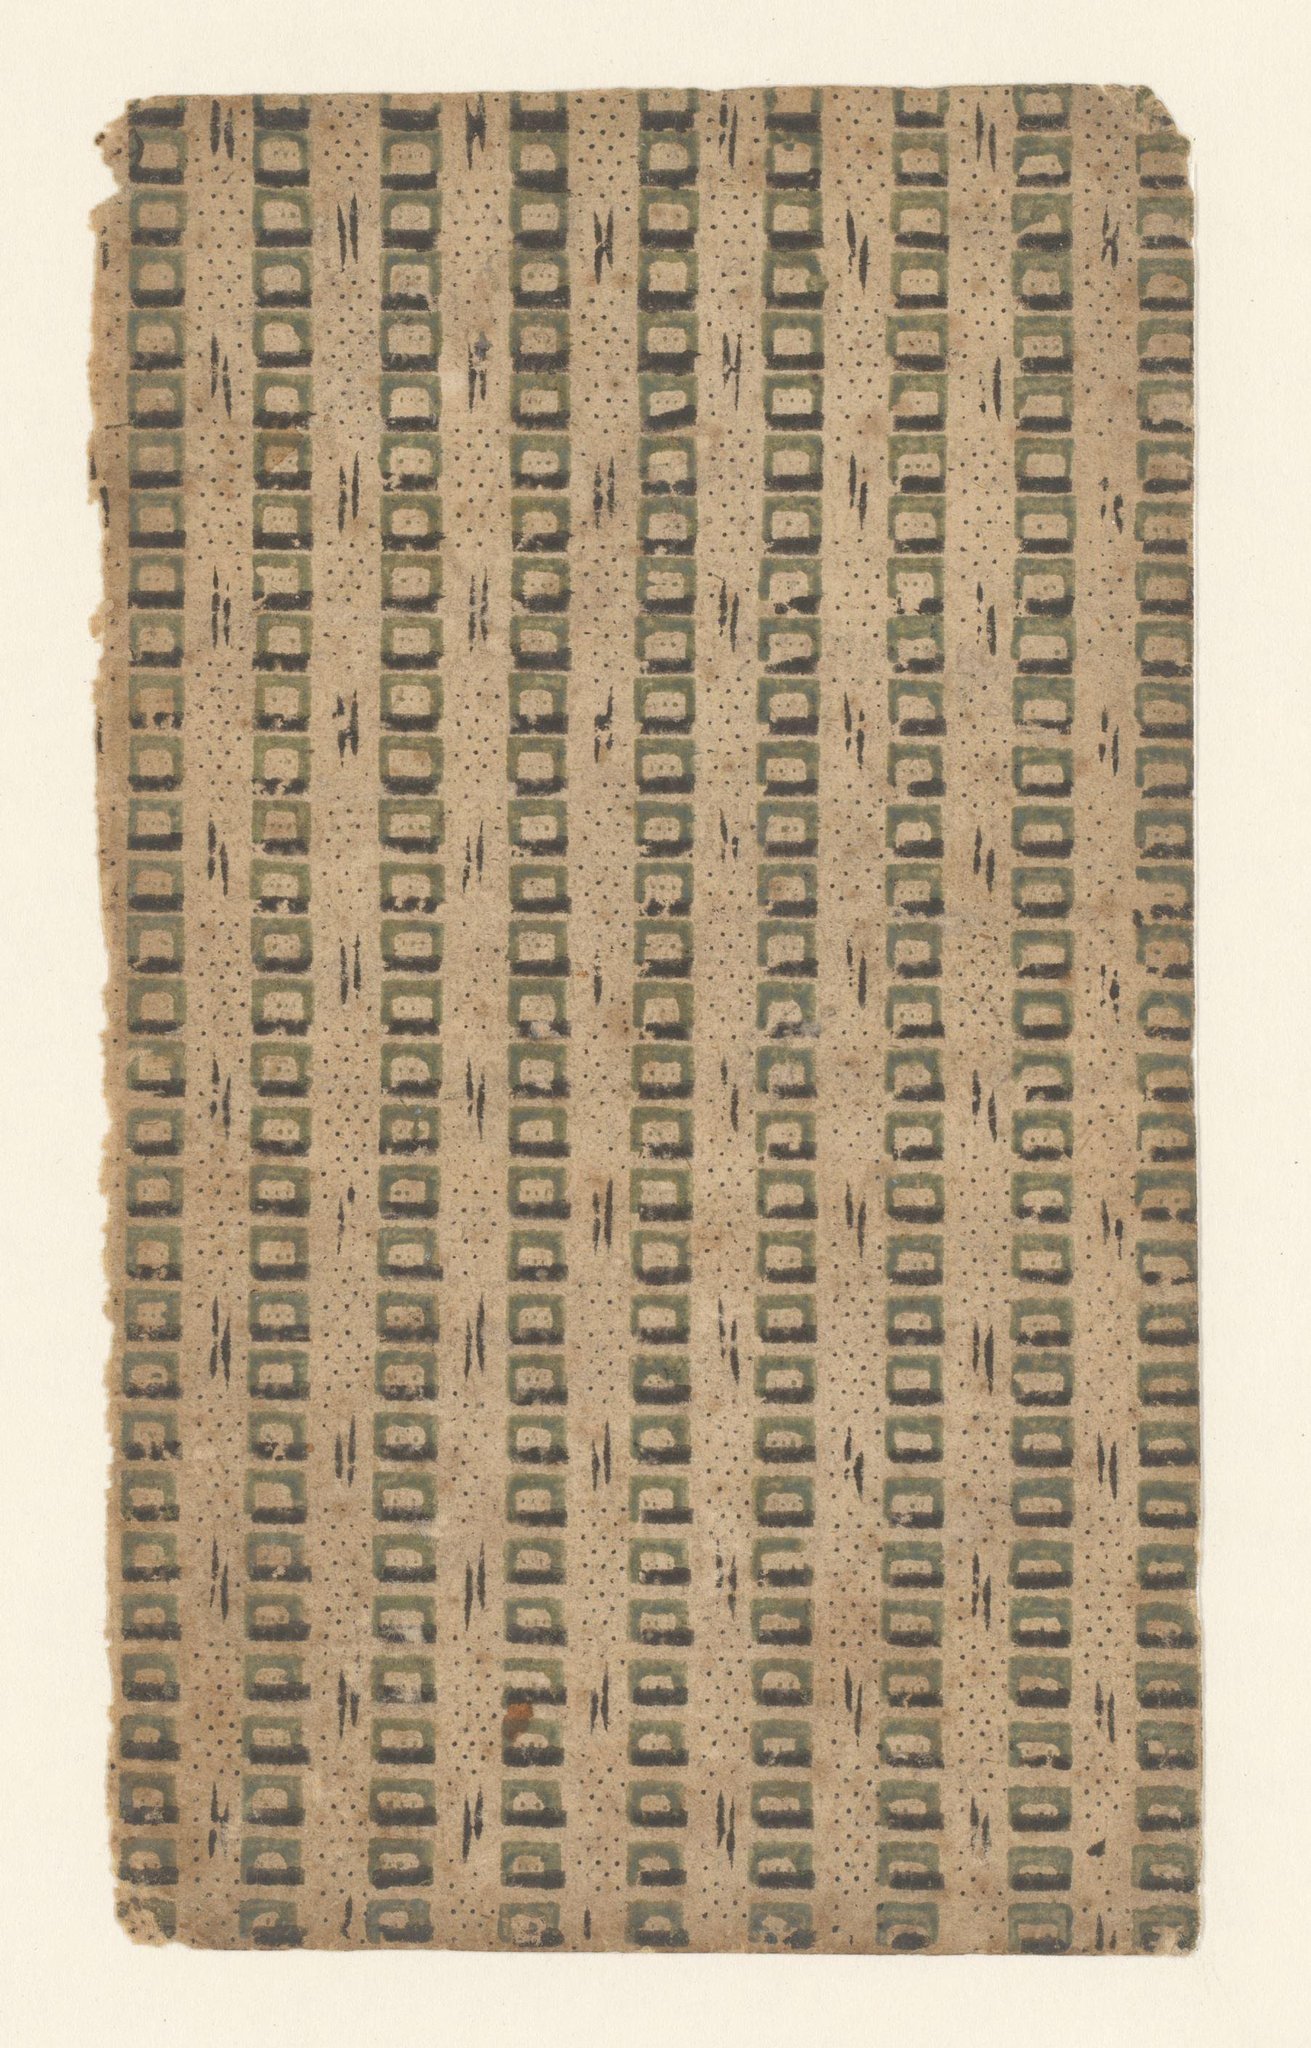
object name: printed paper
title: Blad met banenpatroon van blokken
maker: Anonymous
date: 1700-1850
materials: paper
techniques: printing block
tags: ornament ~ geometric motifs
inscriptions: annotation: ‘jan 82 schumacher’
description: Blad met verticaal banenpatroon van blokken tussen punten en streepjes. Helft van een omslag.